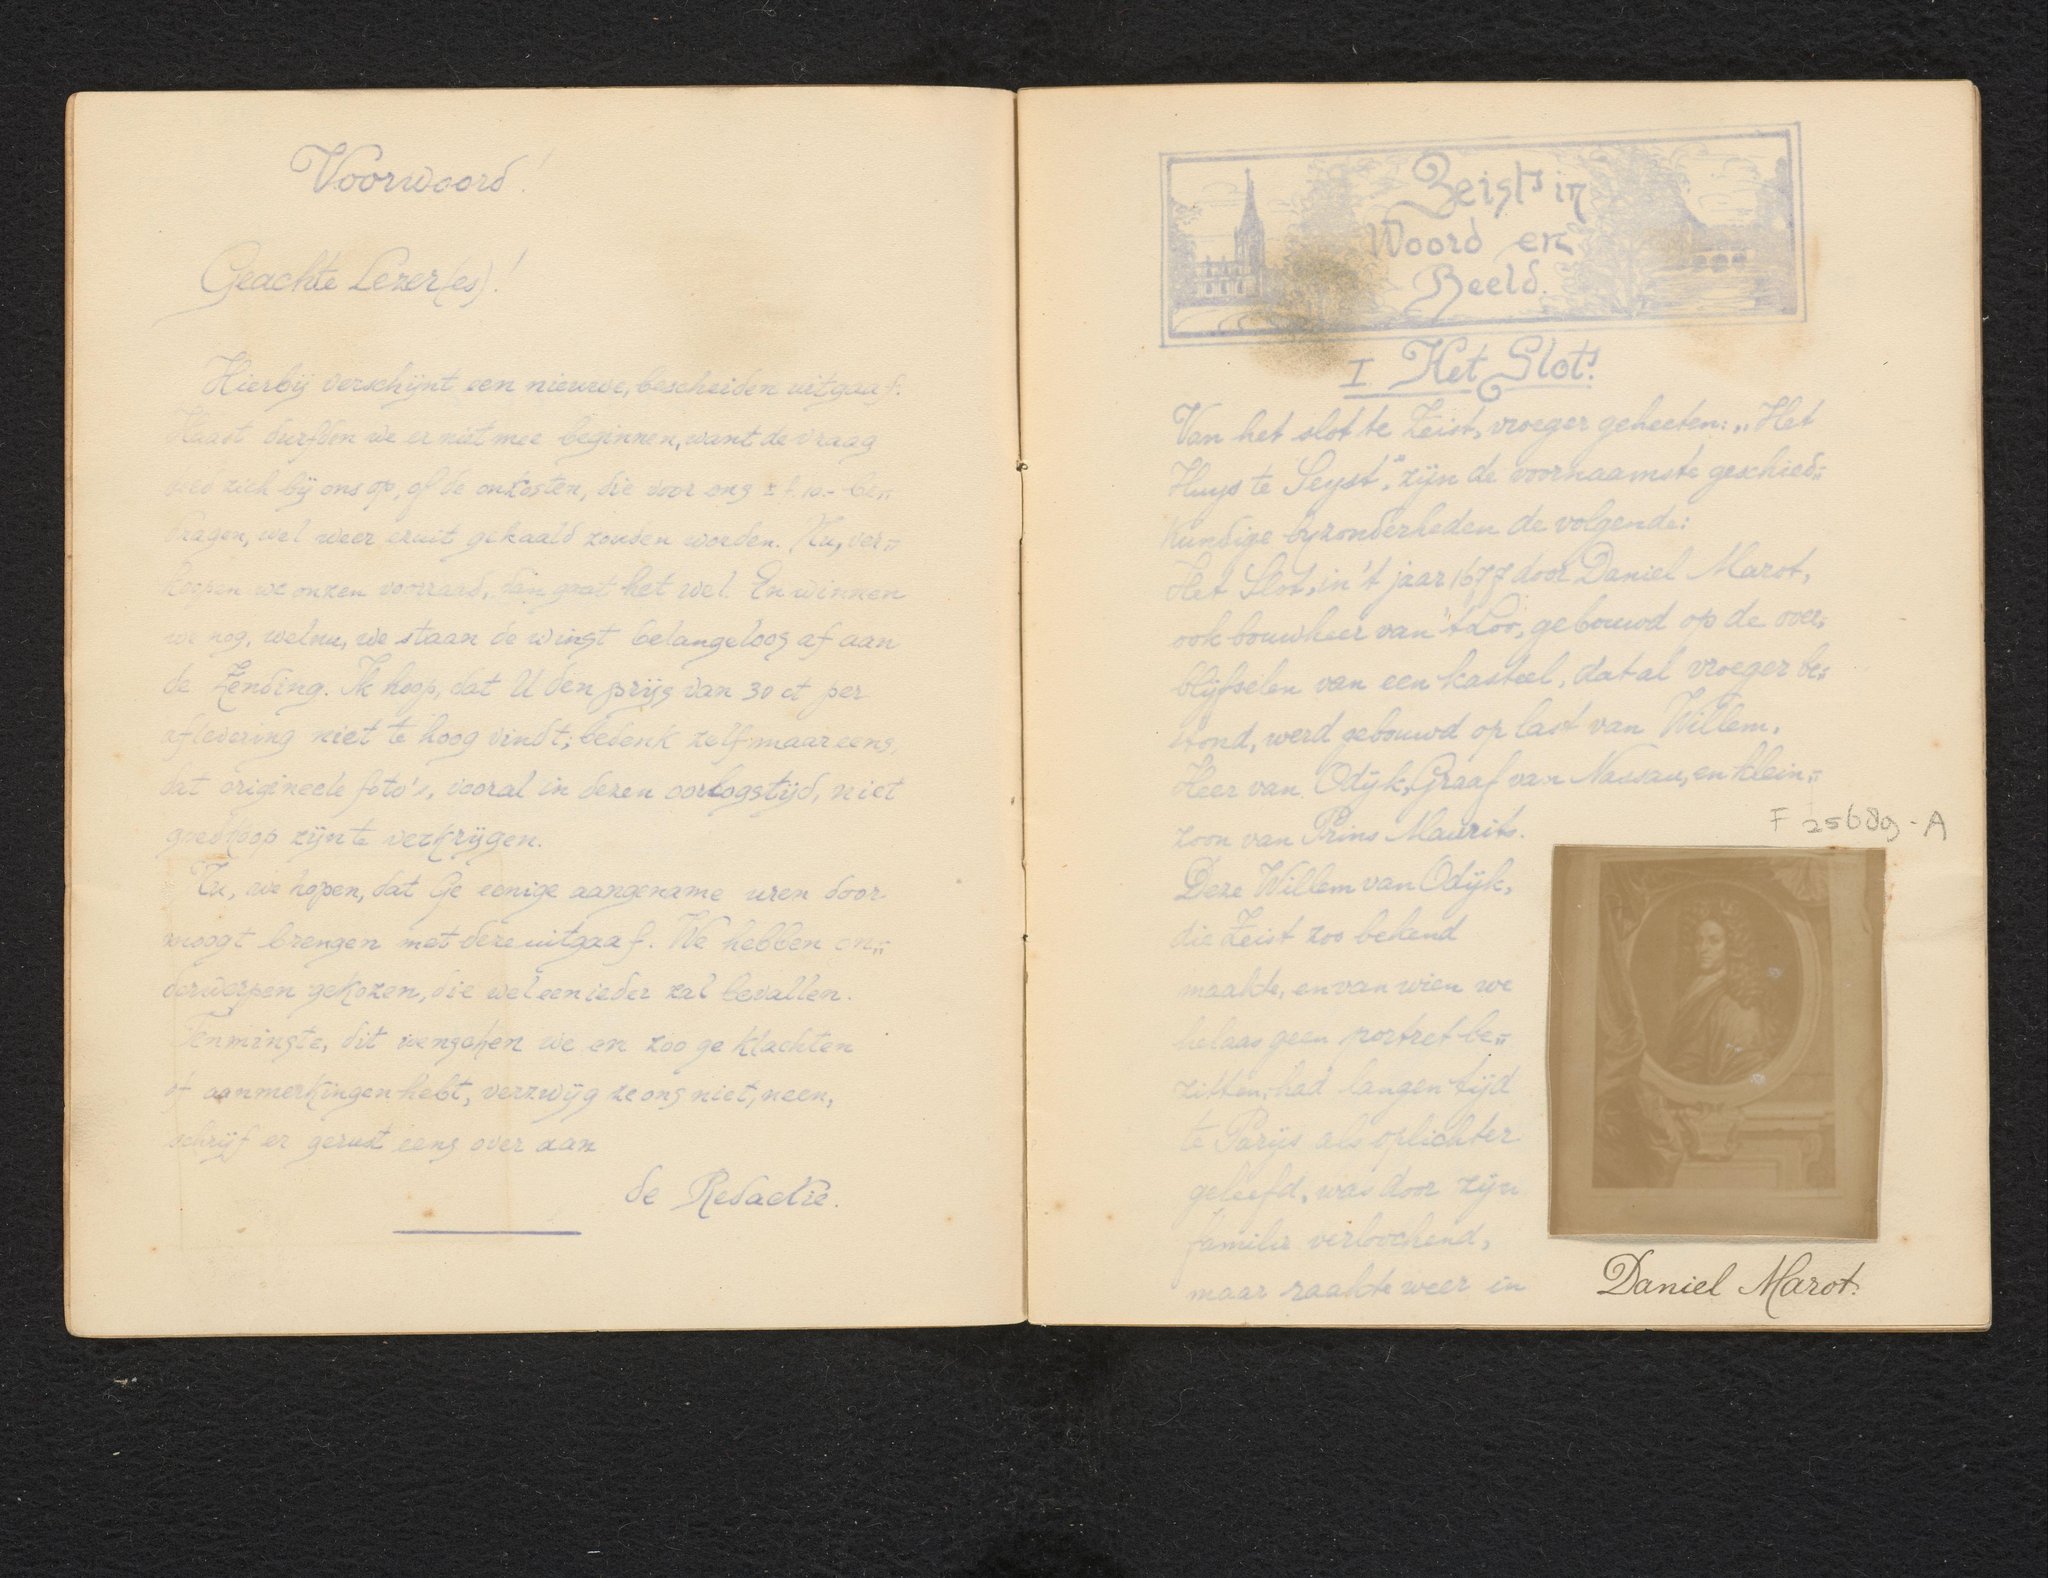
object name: photograph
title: Fotoreproductie van een prent naar een geschilderd portret van Daniël Marot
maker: Anonymous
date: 1911-1916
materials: paper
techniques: gelatin silver print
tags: paris, the hague, print maker, draughtsman, daniël marot (i), historical persons